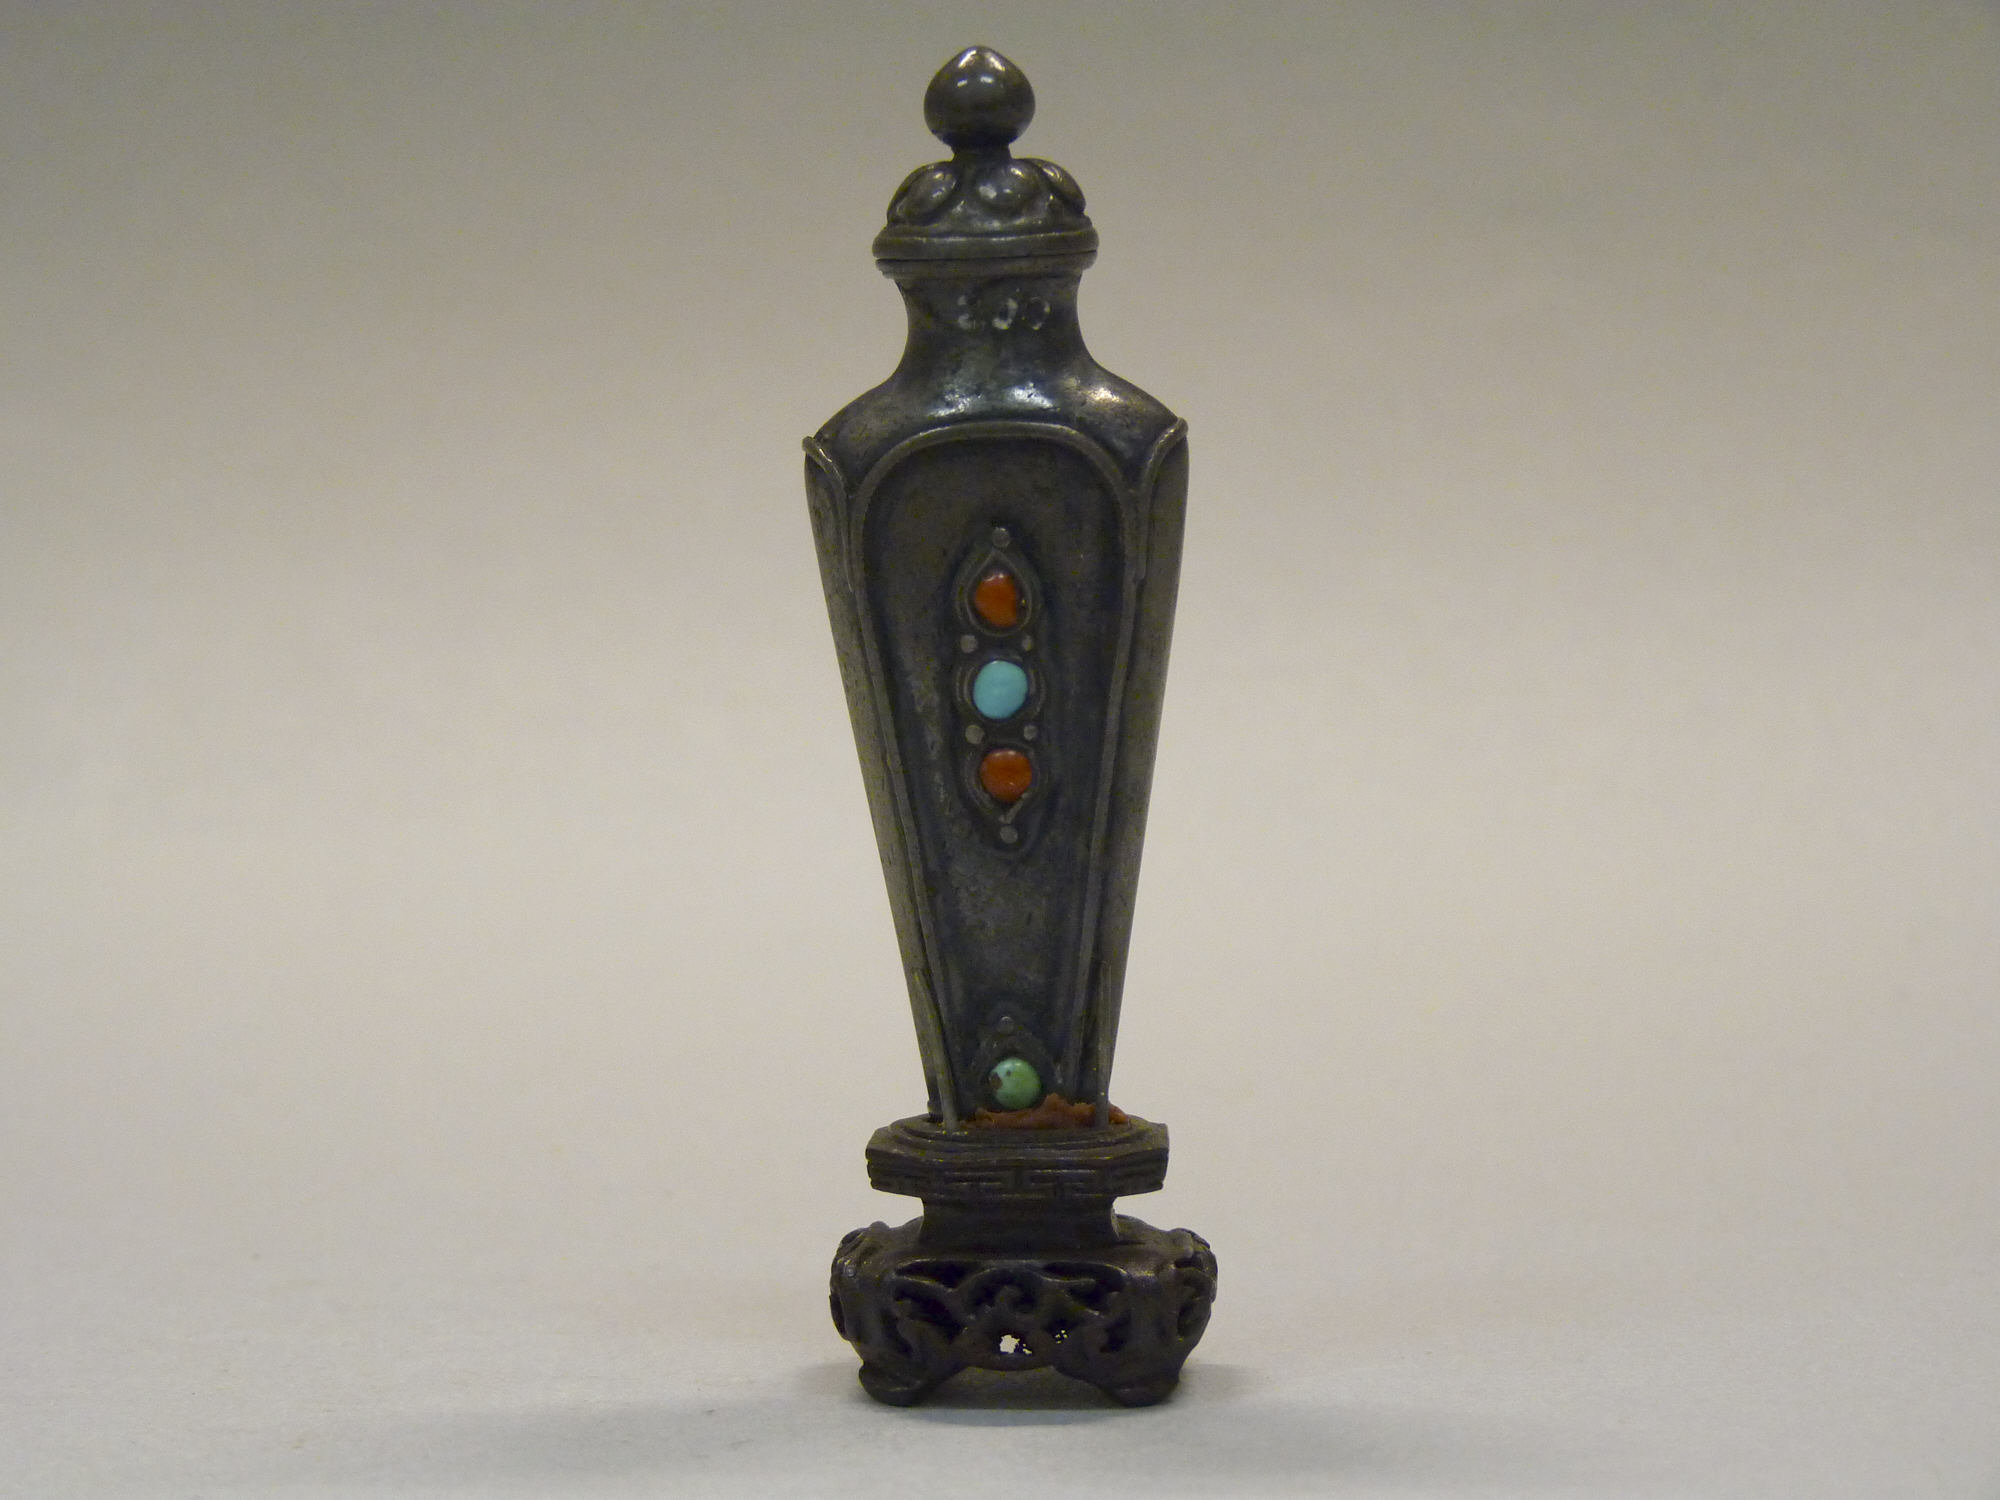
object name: snuff bottle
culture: chinese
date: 1701-1800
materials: silver, stone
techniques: inlay